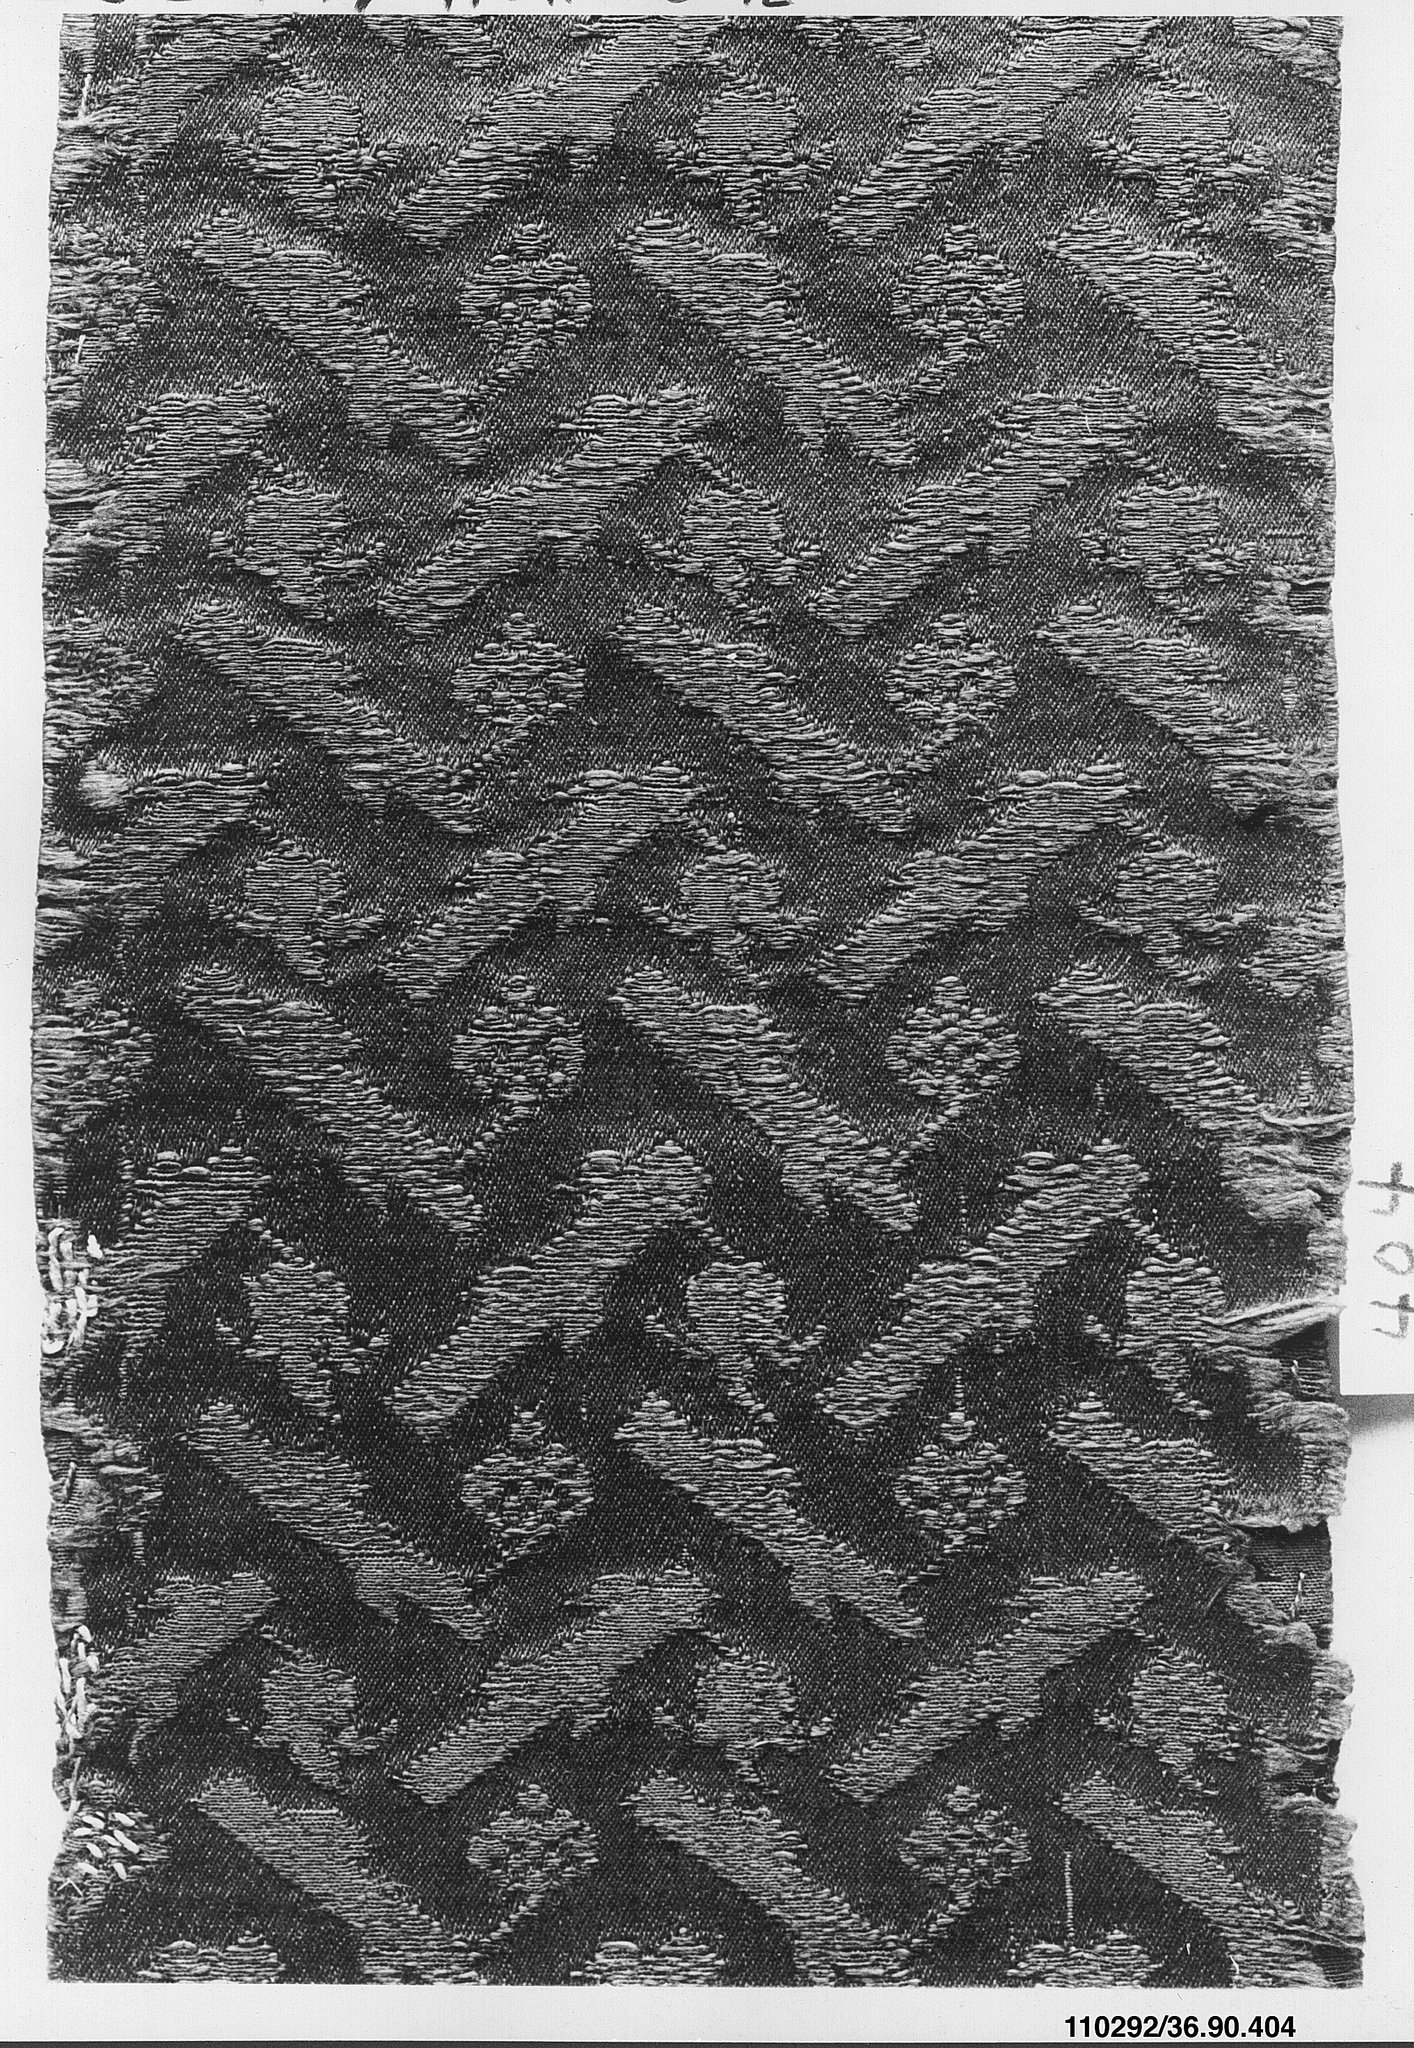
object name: piece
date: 1501-1700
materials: silk